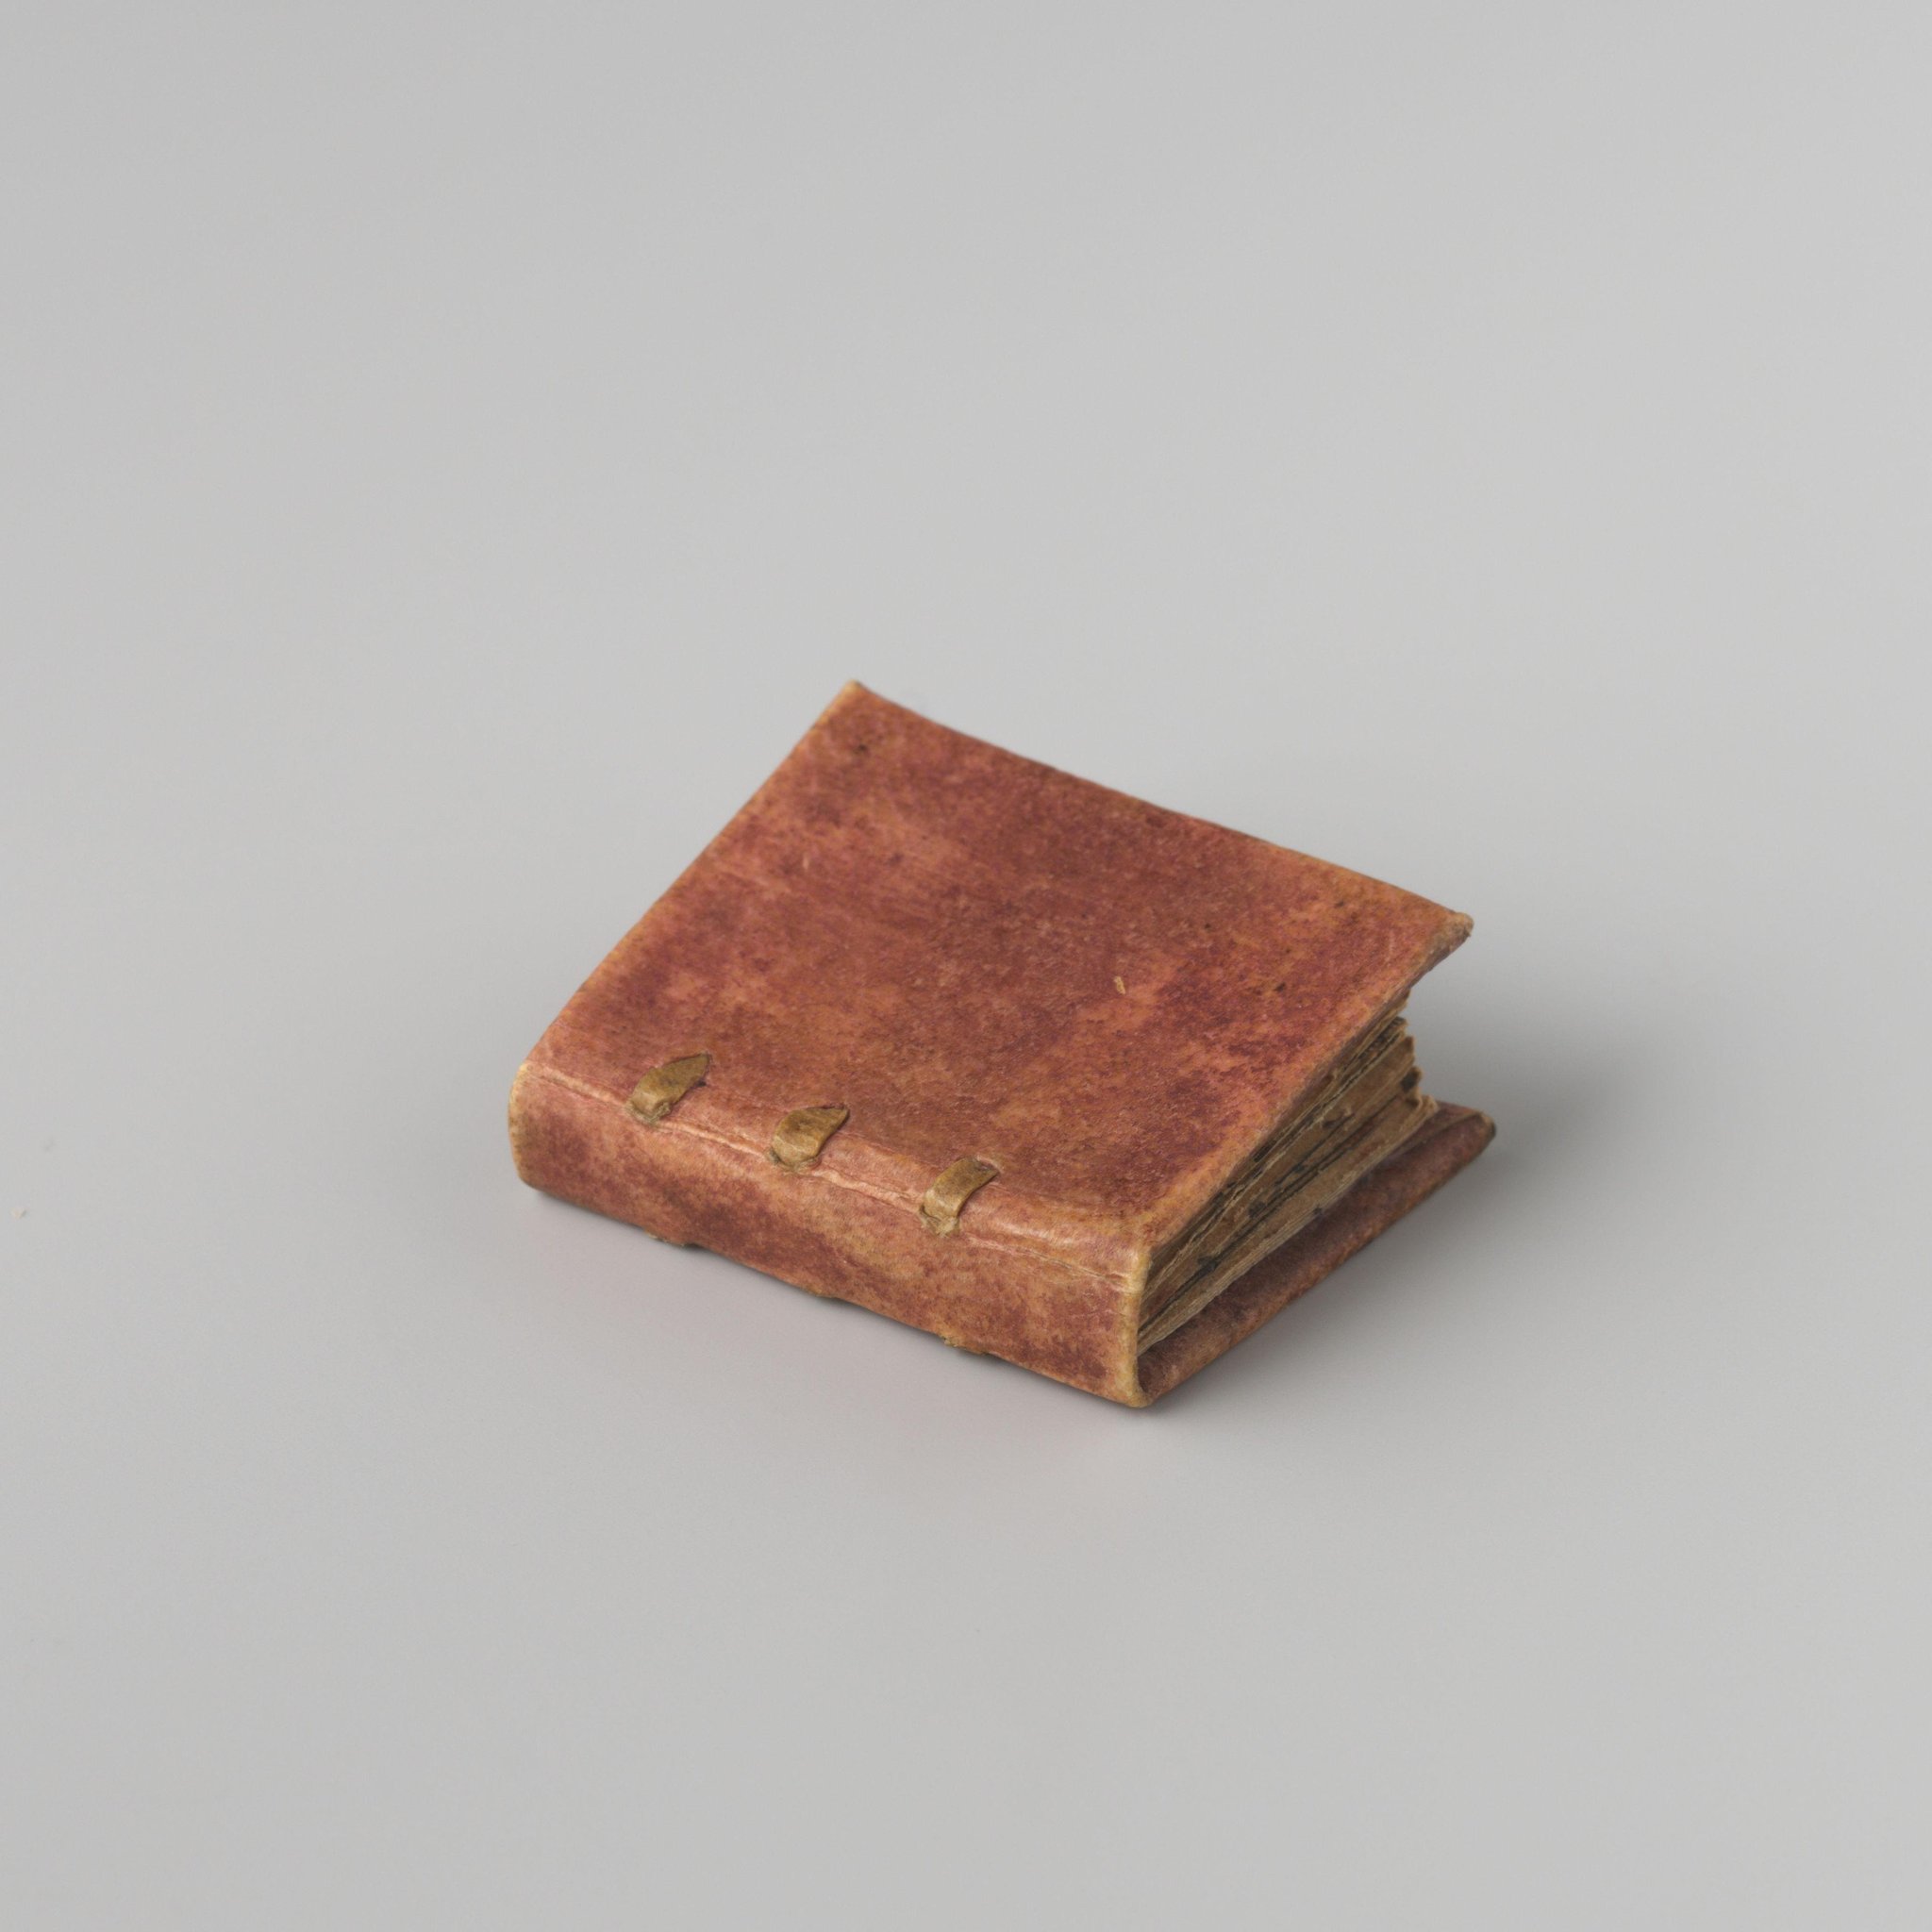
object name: miniature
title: Boek met stads- en tuingezichten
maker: Anonymous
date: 1690-1710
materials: paper, parchment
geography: amsterdam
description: Boek met stads- en tuingezichten. Ingebonden in roze gekleurd perkament.